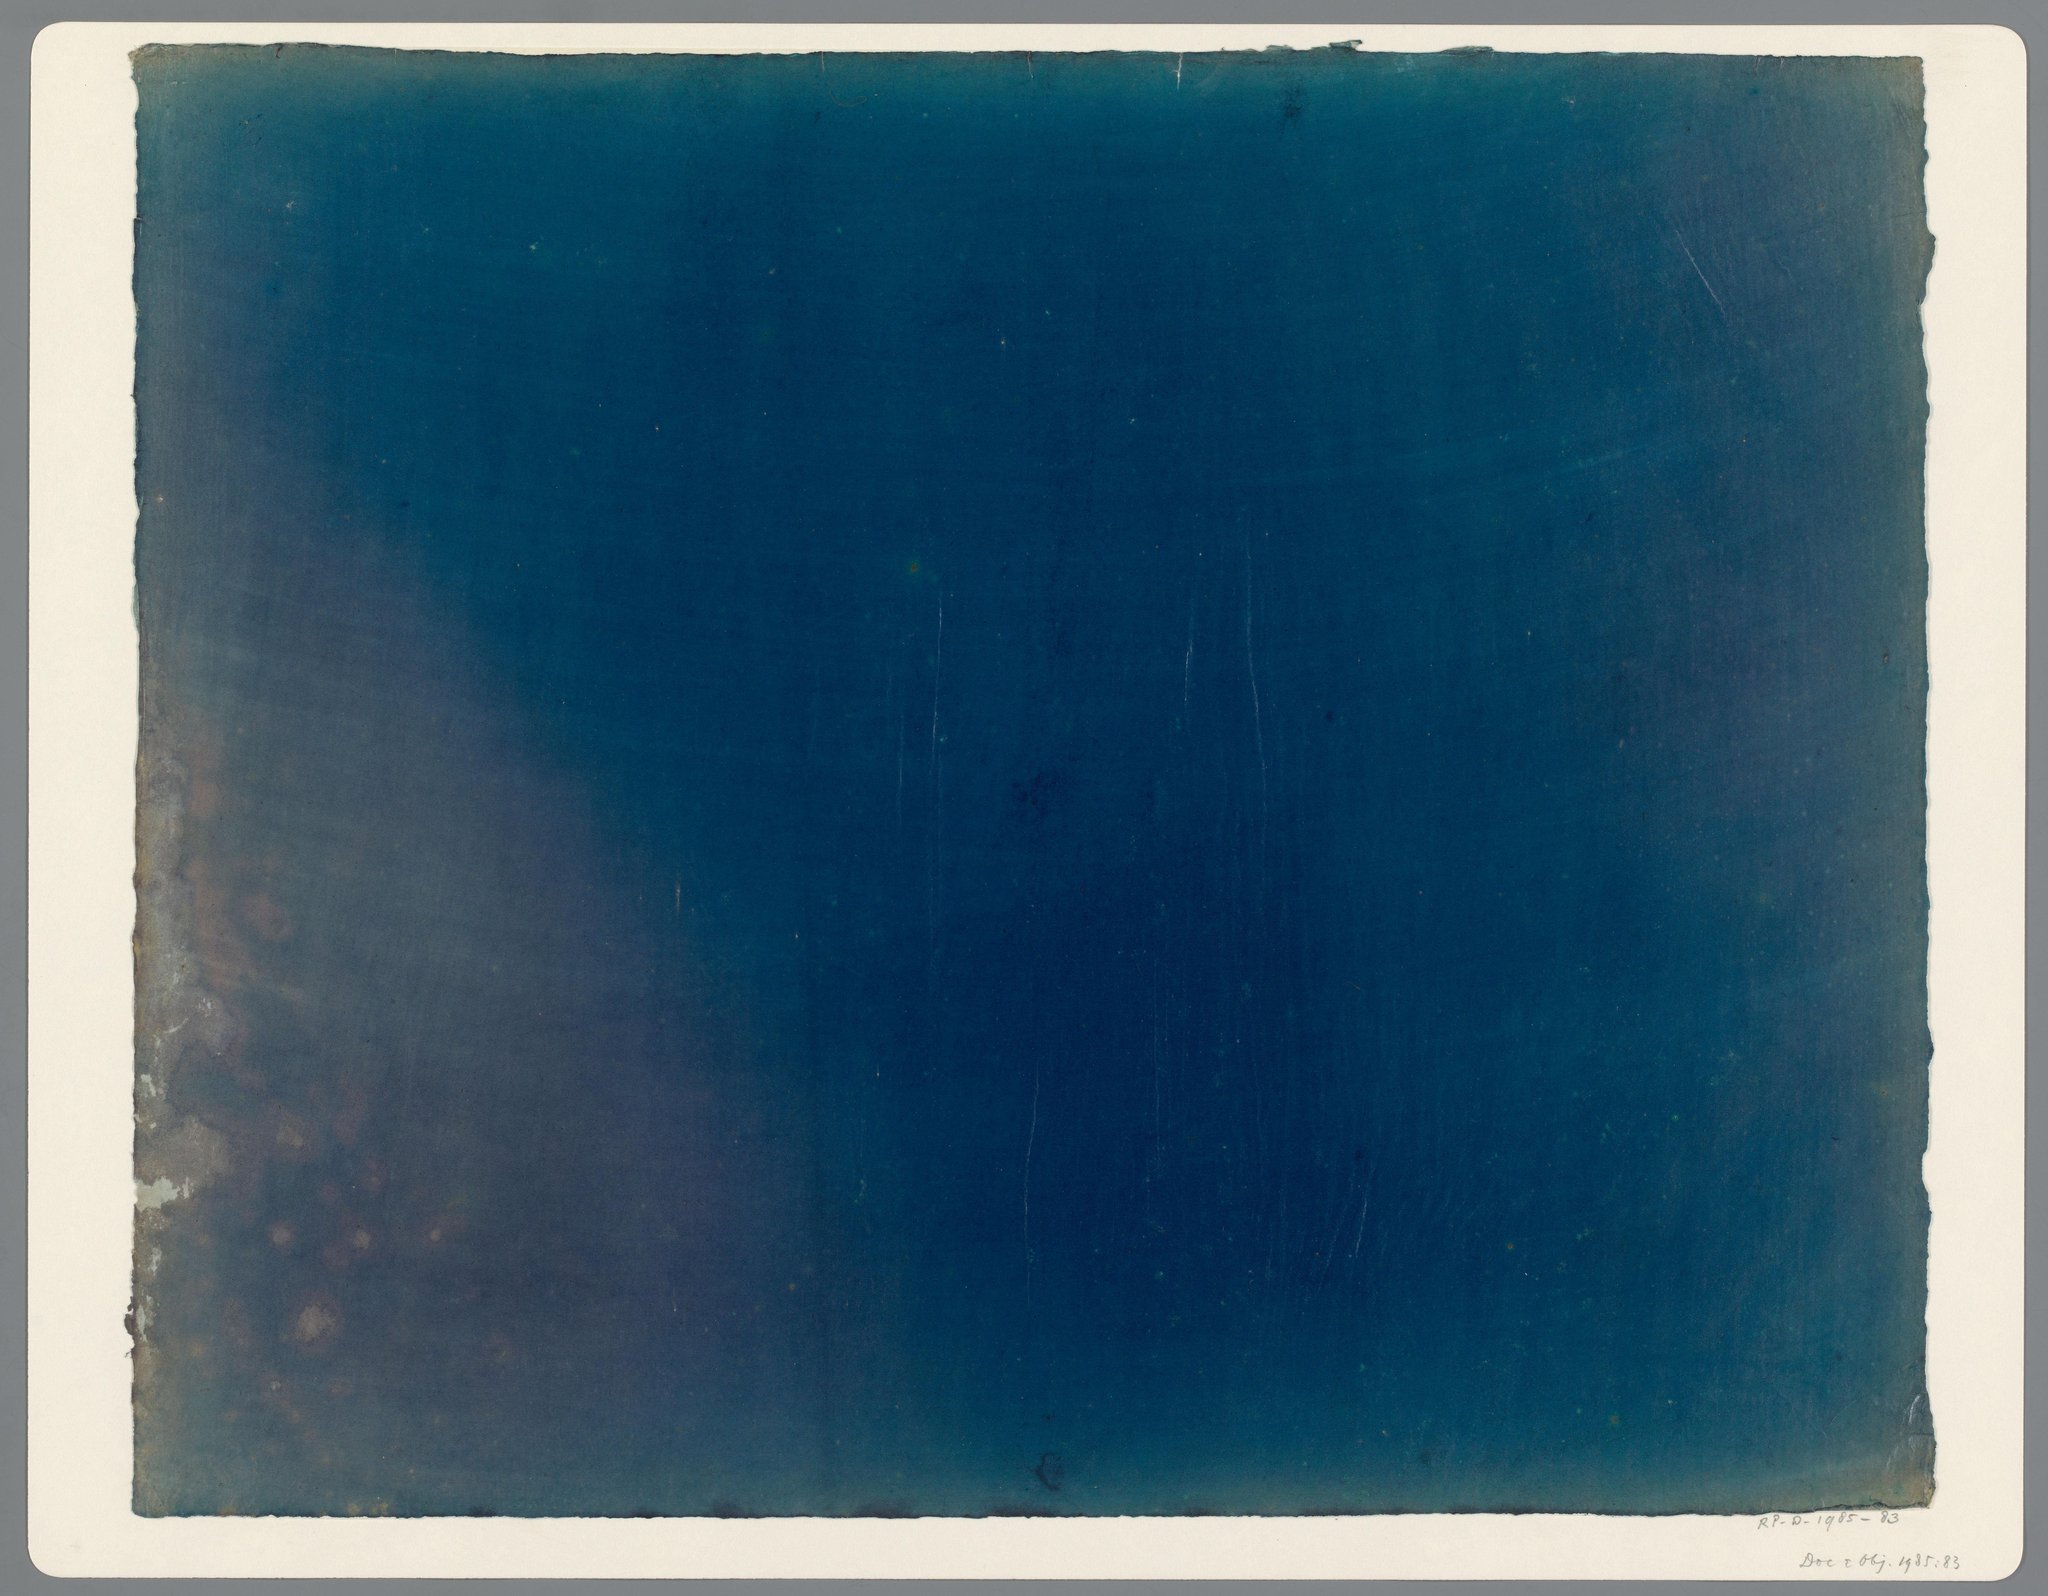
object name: decorated paper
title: Effen blauw papier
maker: Anonymous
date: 1800-1950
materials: lacquer, paint, paper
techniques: hand coloring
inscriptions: collector's mark: Lugt 2760, collector's mark: Lugt 2228